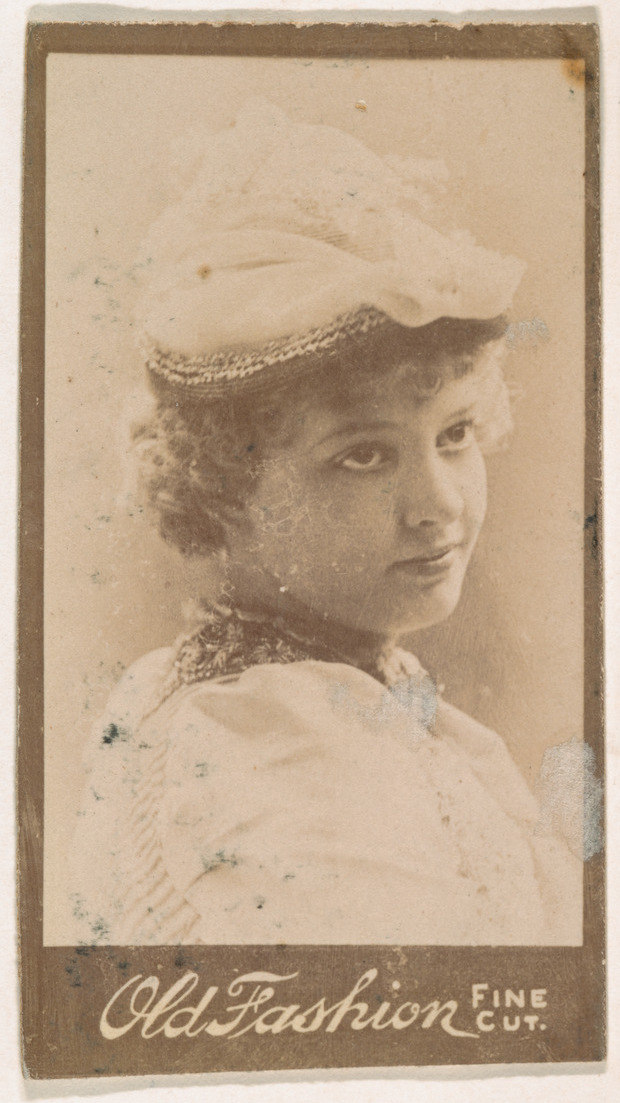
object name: photograph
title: Actress with short hair wearing cap, from the Actresses series (N664) promoting Old Fashion Fine Cut Tobacco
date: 1888-1890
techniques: albumen silver print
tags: portraits,women,actresses